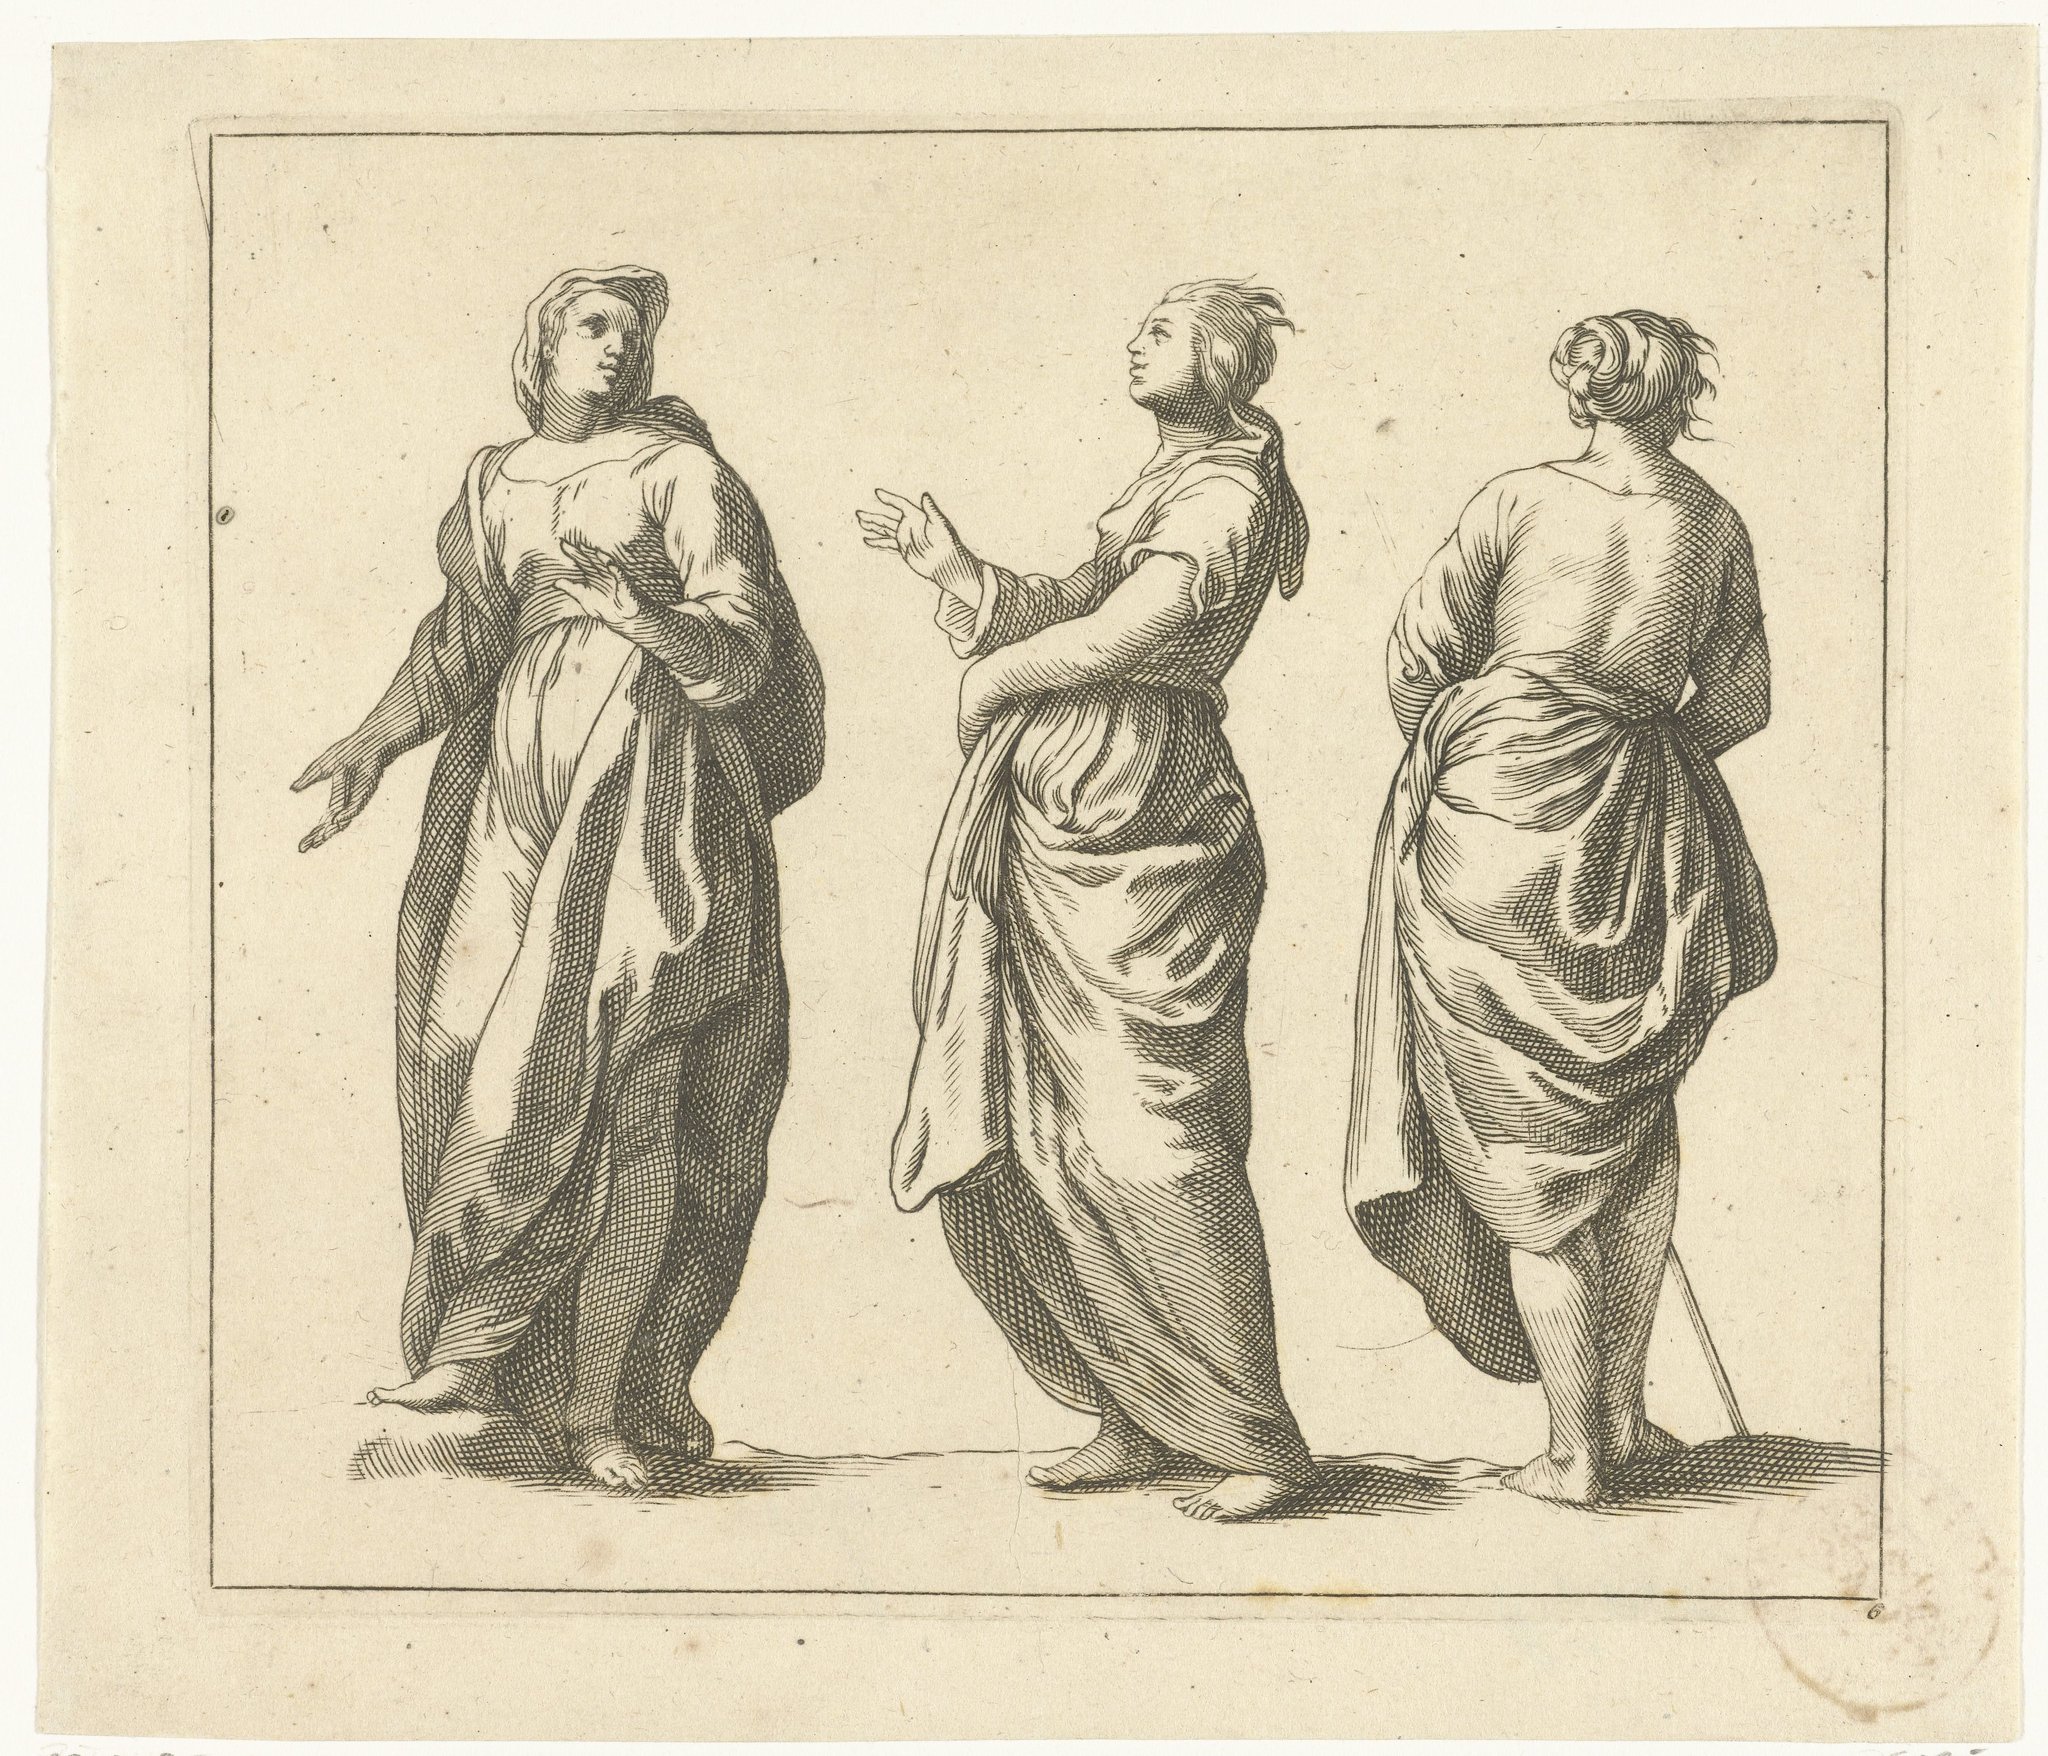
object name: print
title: Verscheyde aerdige figure van vrouwen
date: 1670-1706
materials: paper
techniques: engraving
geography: amsterdam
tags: adult woman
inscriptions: collector's mark: Lugt 240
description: Drie vrouwen in losse kleding: vooraanzicht, zijwaarts en op de rug gezien. Prent zes uit een serie prenten naar figuren uit het tekenboek van Abraham Bloemaert.